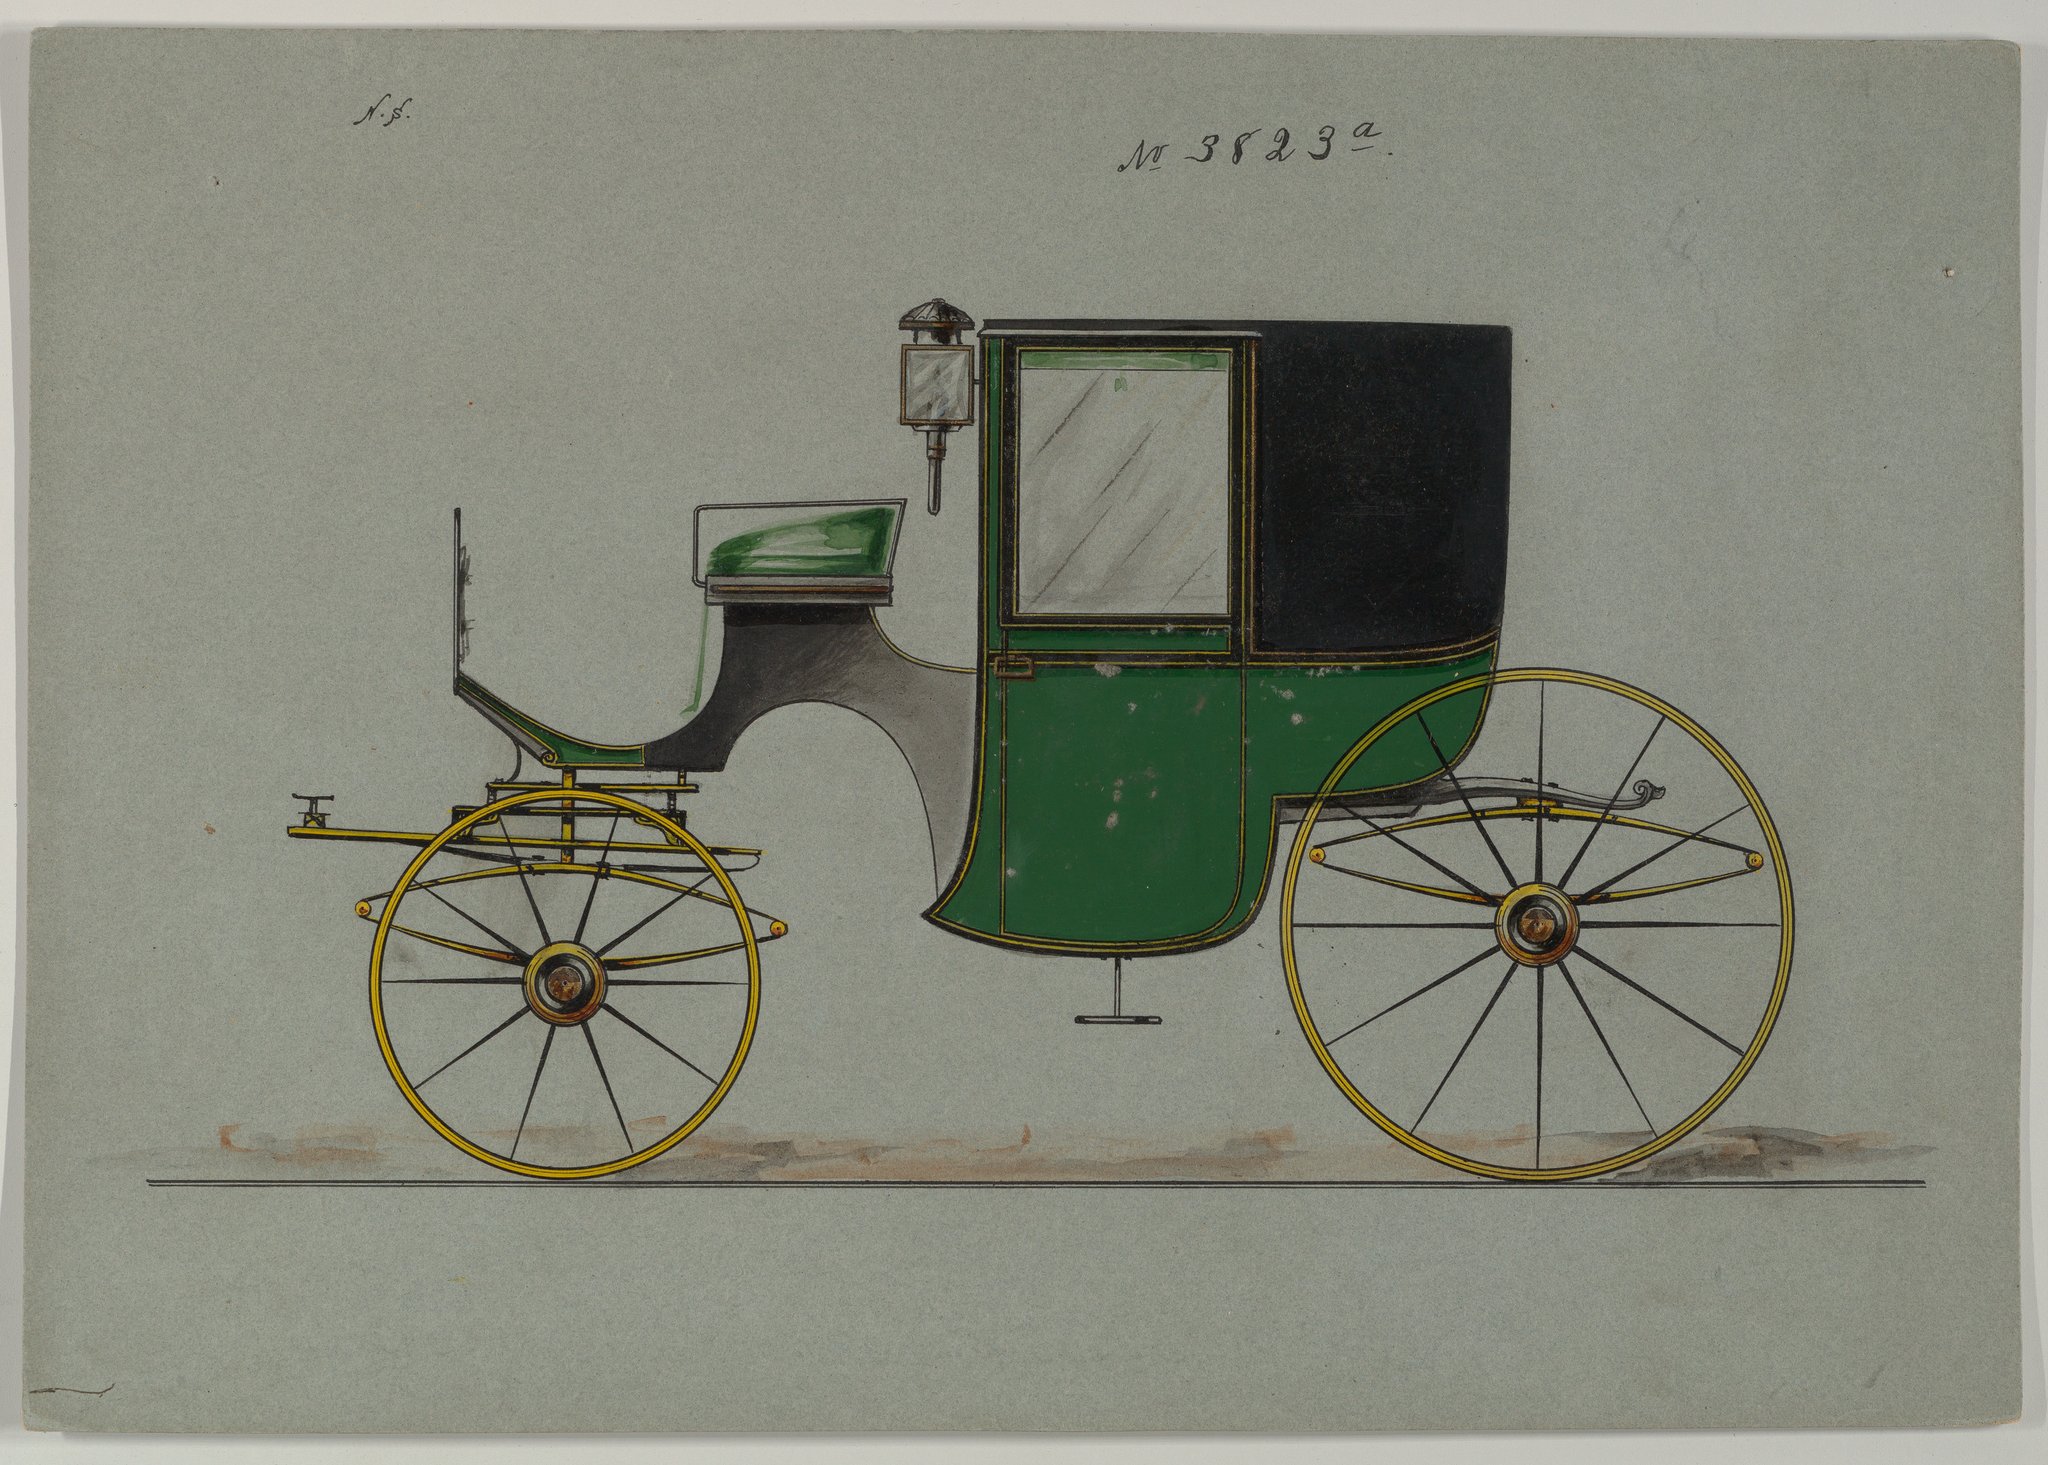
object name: drawing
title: Brougham #3823a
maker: brewster & co.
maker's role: manufacturer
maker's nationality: american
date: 1883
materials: gouache, gum arabic, ink, watercolor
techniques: pen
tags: carriages